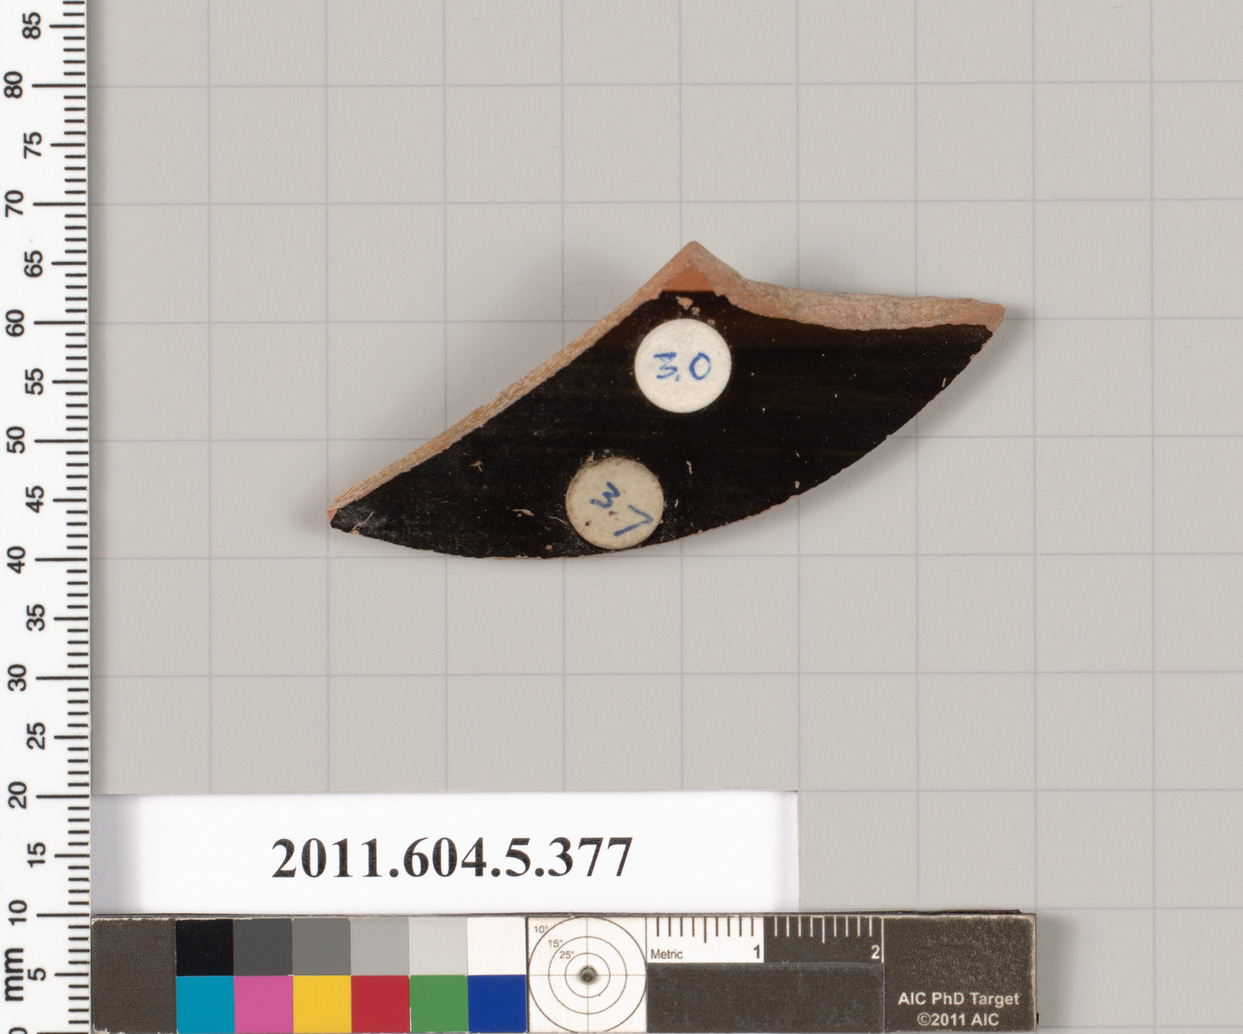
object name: kylix fragment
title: Terracotta fragment of a kylix (drinking cup)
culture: greek, attic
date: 600-401 BCE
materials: terracotta